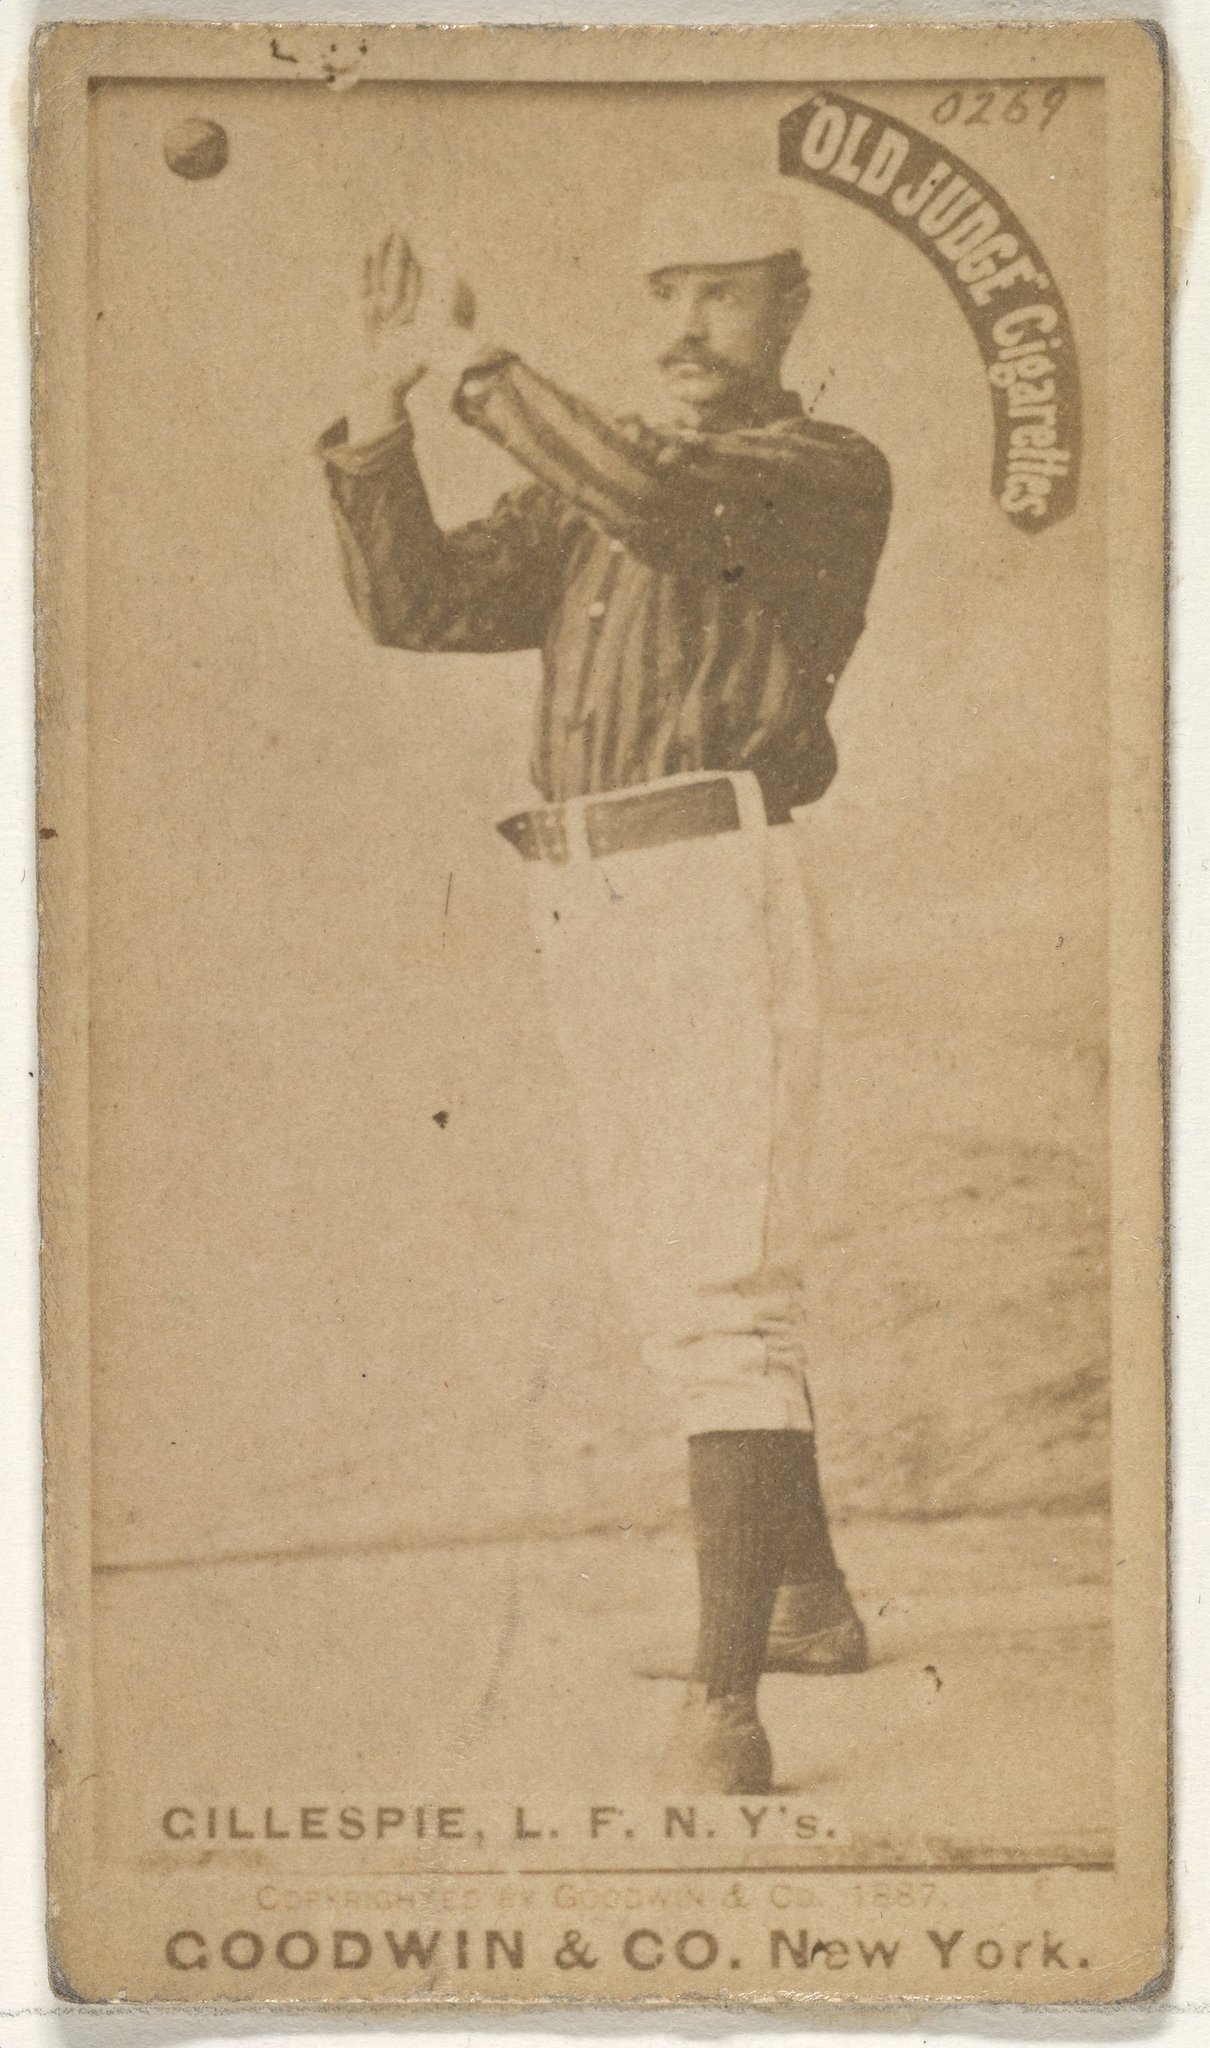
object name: baseball card, photograph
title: Peter Patrick Gillespie, Left Field, New York, from the Old Judge series (N172) for Old Judge Cigarettes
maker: goodwin & company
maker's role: publisher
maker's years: 1850-1950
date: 1887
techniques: albumen silver print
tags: men,portraits,baseball,athletes